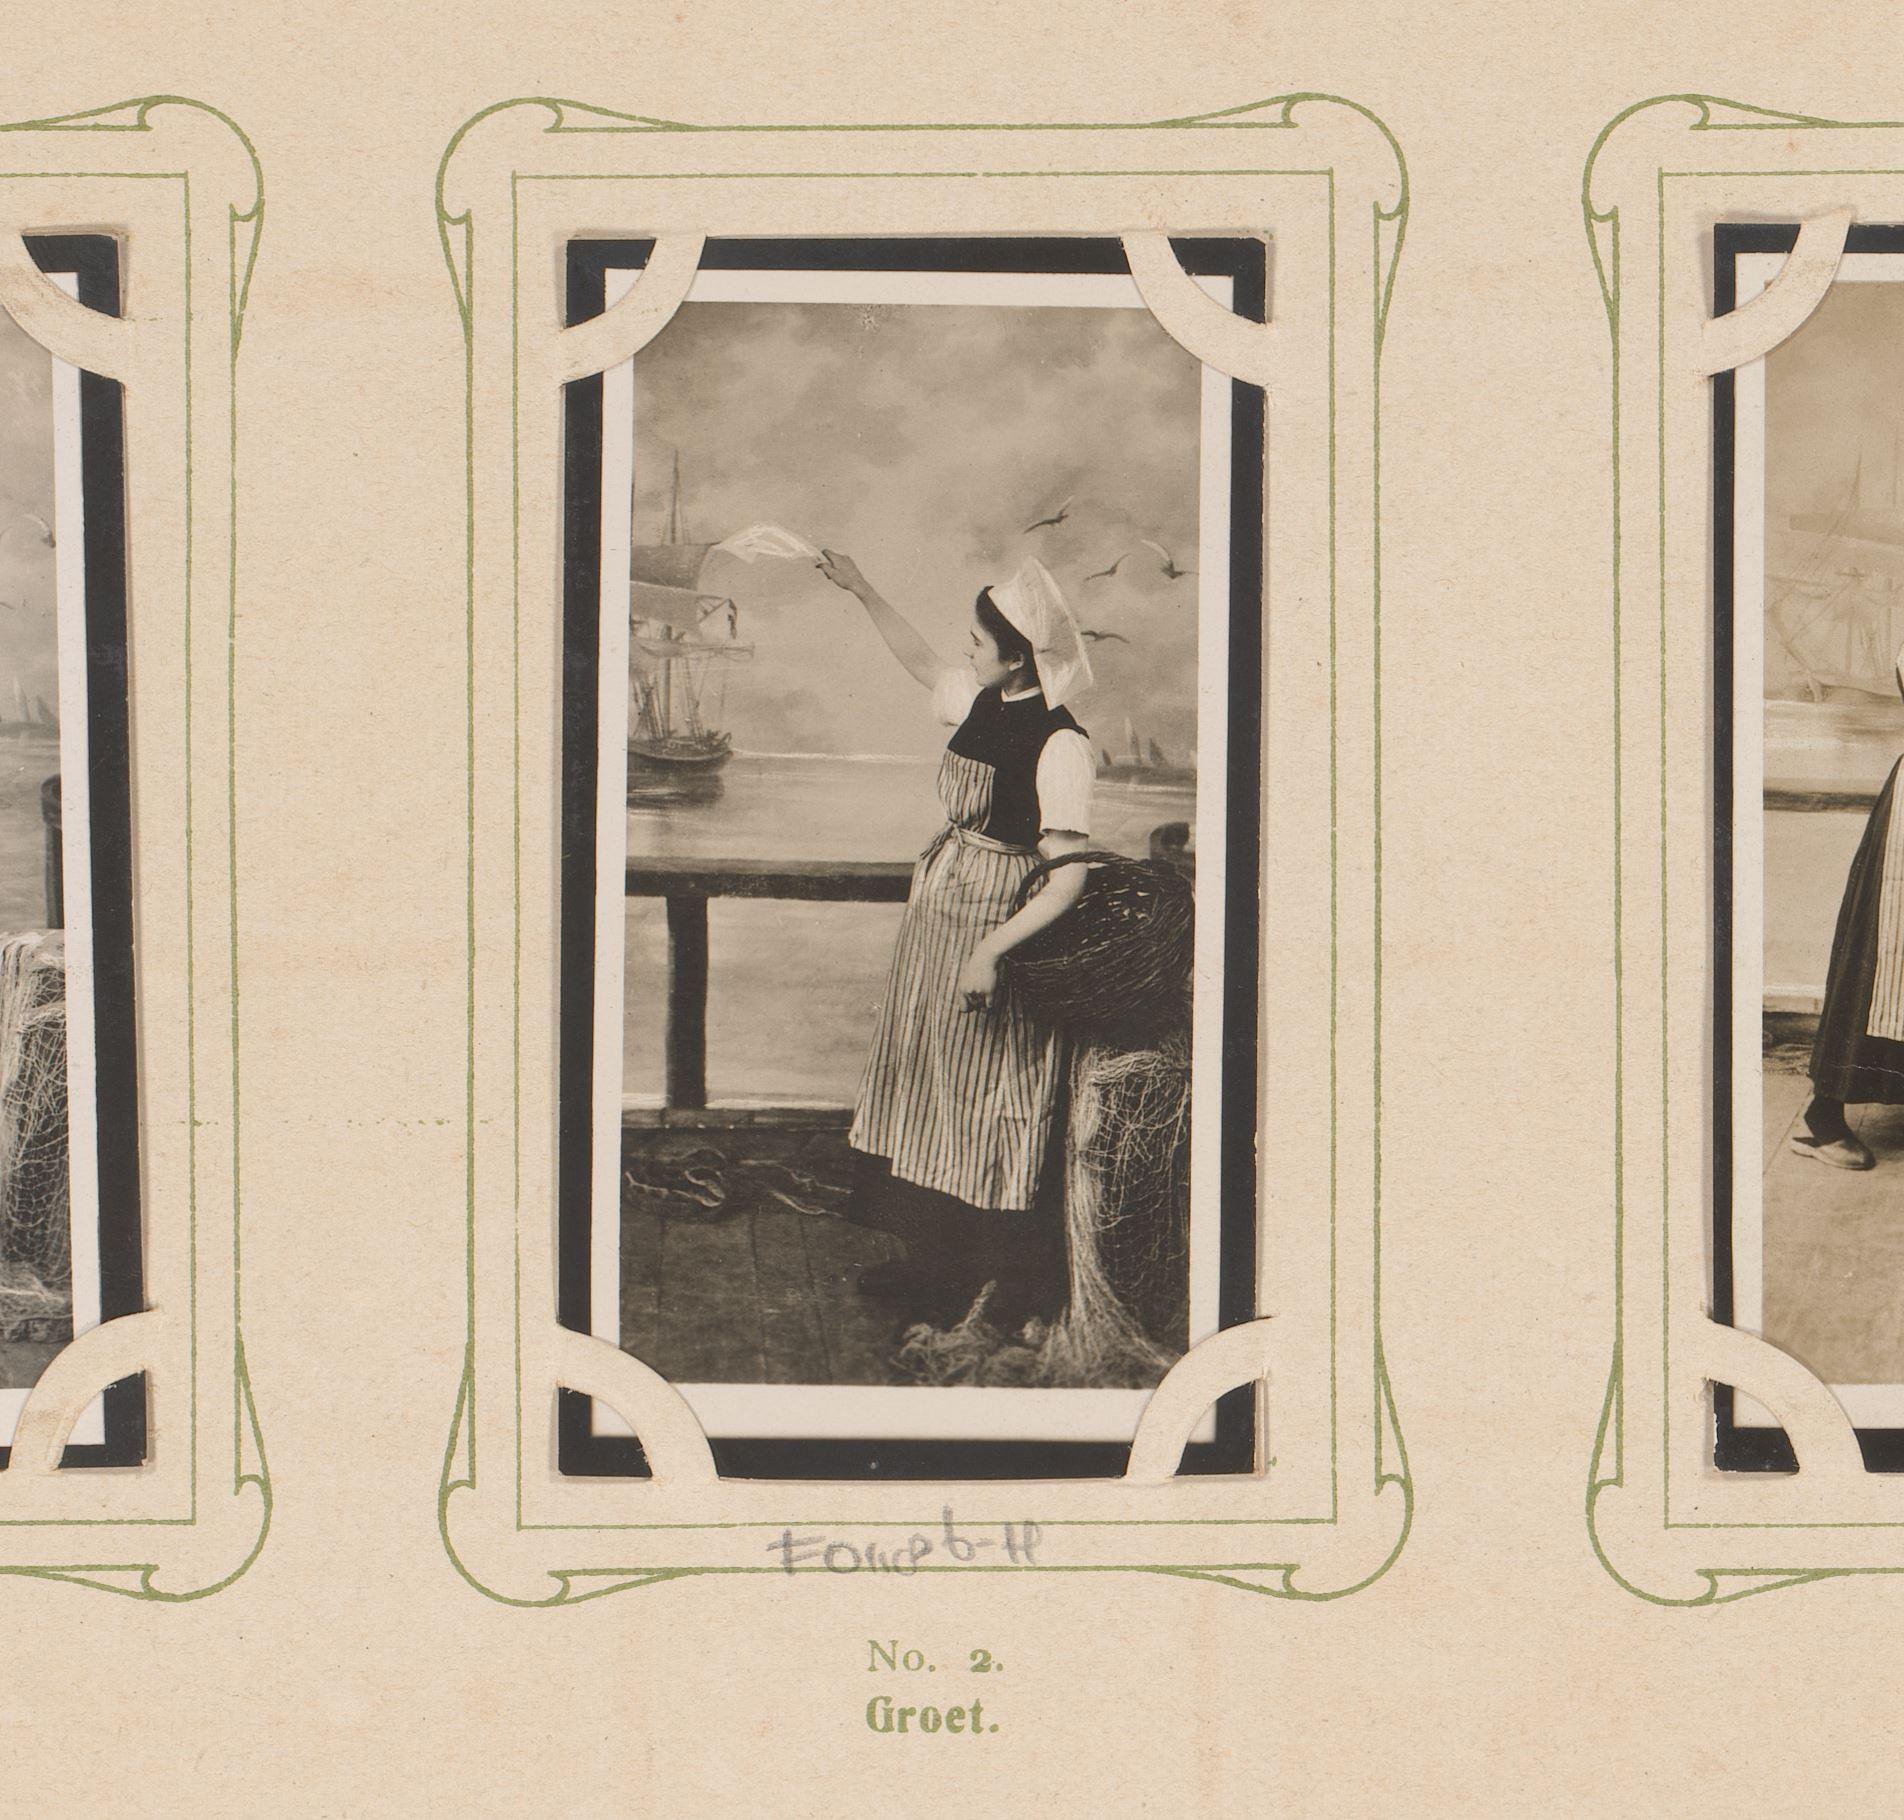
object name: photograph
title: Vrouw zwaait met zakdoek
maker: Anonymous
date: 1904-1905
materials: photographic support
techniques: gelatin silver print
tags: adult woman, handkerchief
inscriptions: inscription: ‘No. 2./ Groet.’